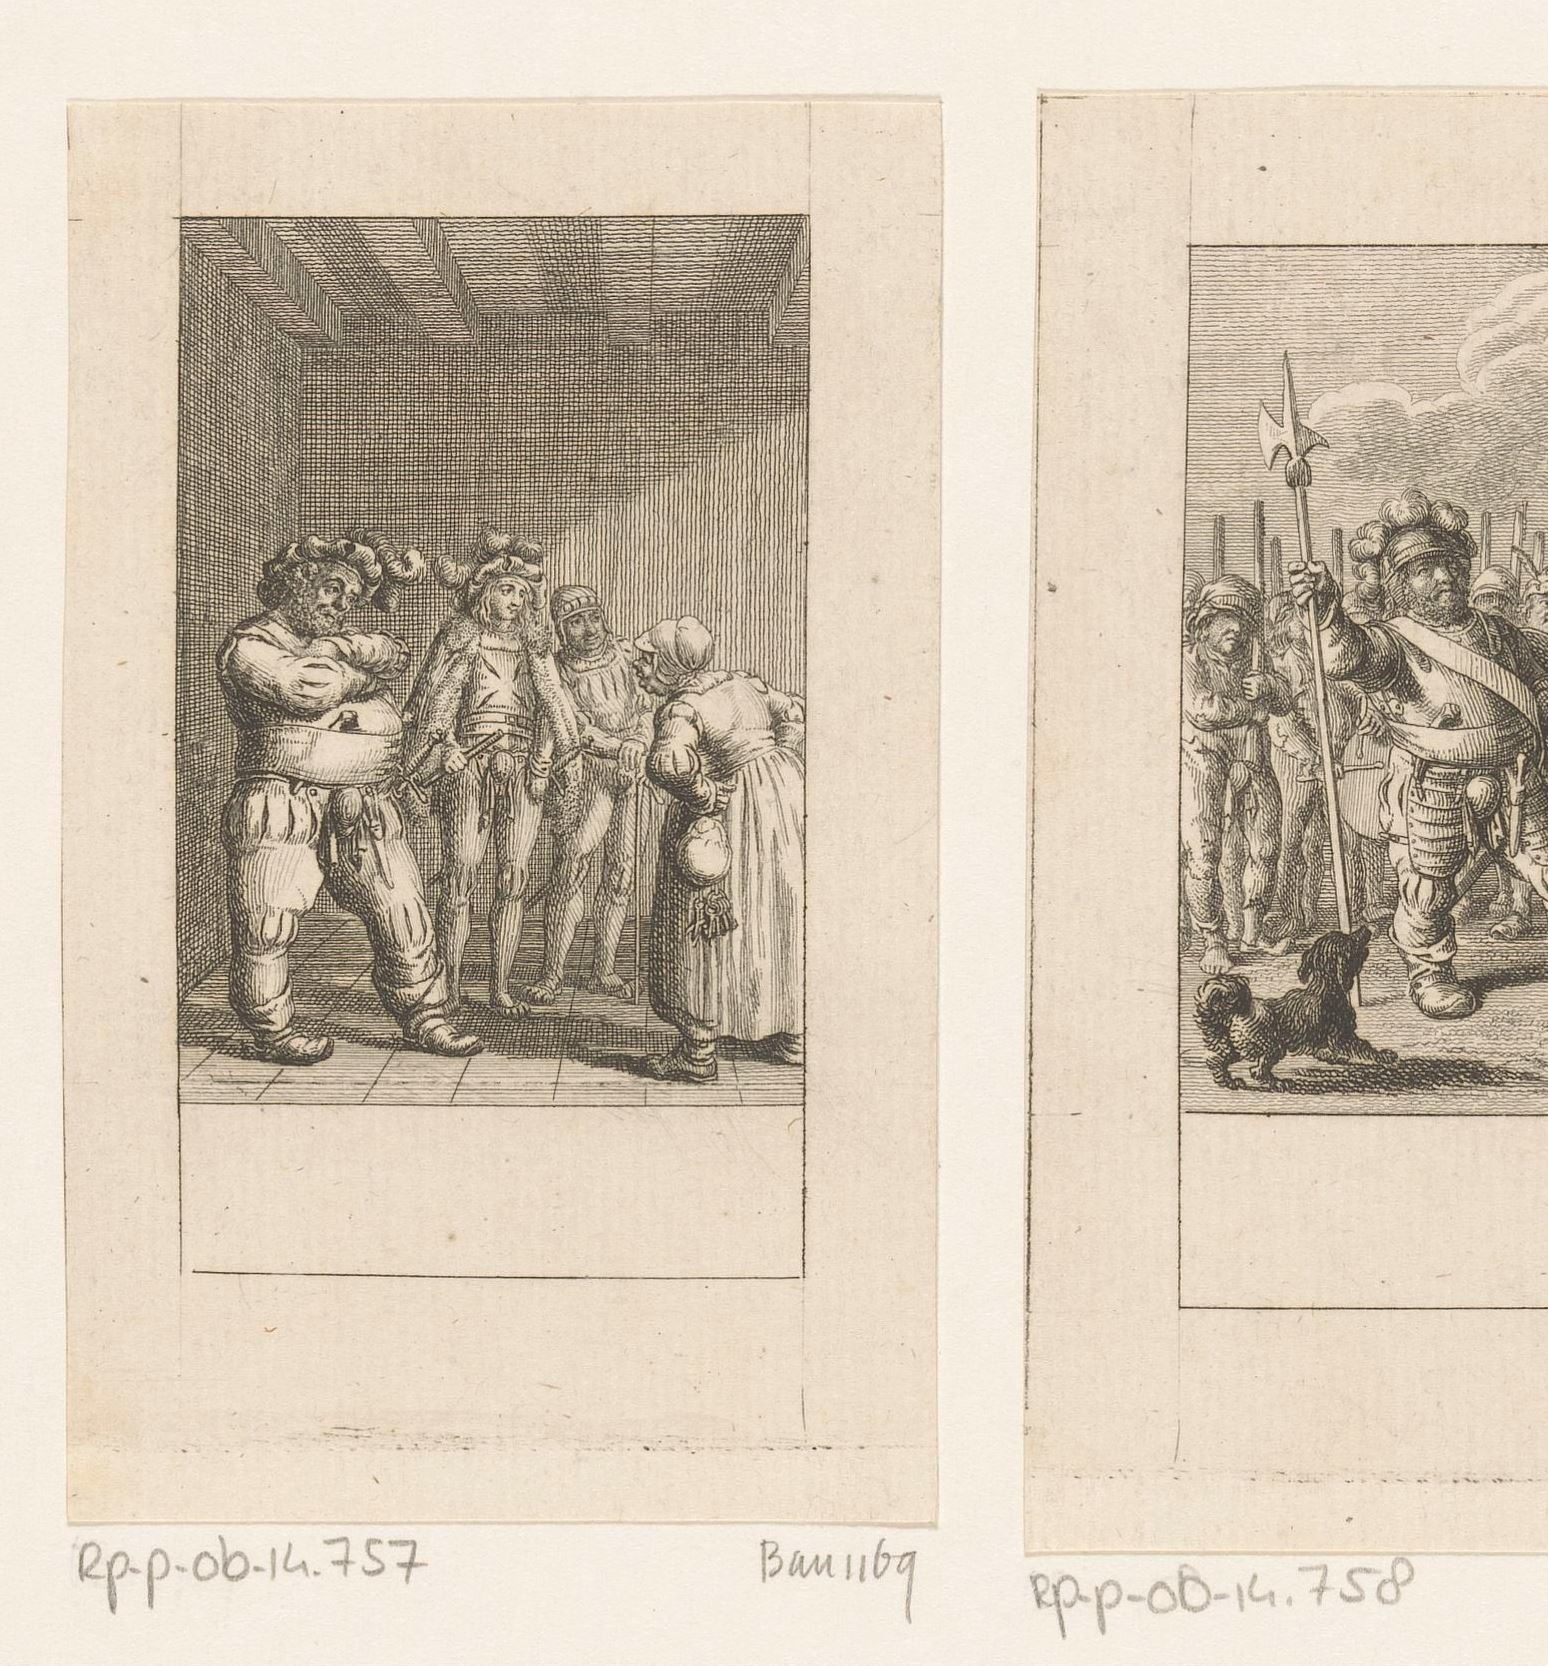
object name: print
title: Ruzie tussen Falstaff en de waardin in bijzijn van Henry en Bardolph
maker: daniel nikolaus chodowiecki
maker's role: draughtsman, print maker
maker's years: 1726-1801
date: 1785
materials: paper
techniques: etching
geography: berlin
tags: william shakespeare, literature, quarrel, argument, falstaff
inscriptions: collector's mark: Lugt 2228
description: Vervaardigd voor William Shakespeares 'Henry IV'. Latere staat gebruikt voor: Goettinger Taschen Calender vom Jahr 1786. Göttingen: Johann Christoph Dietrich, 1785.